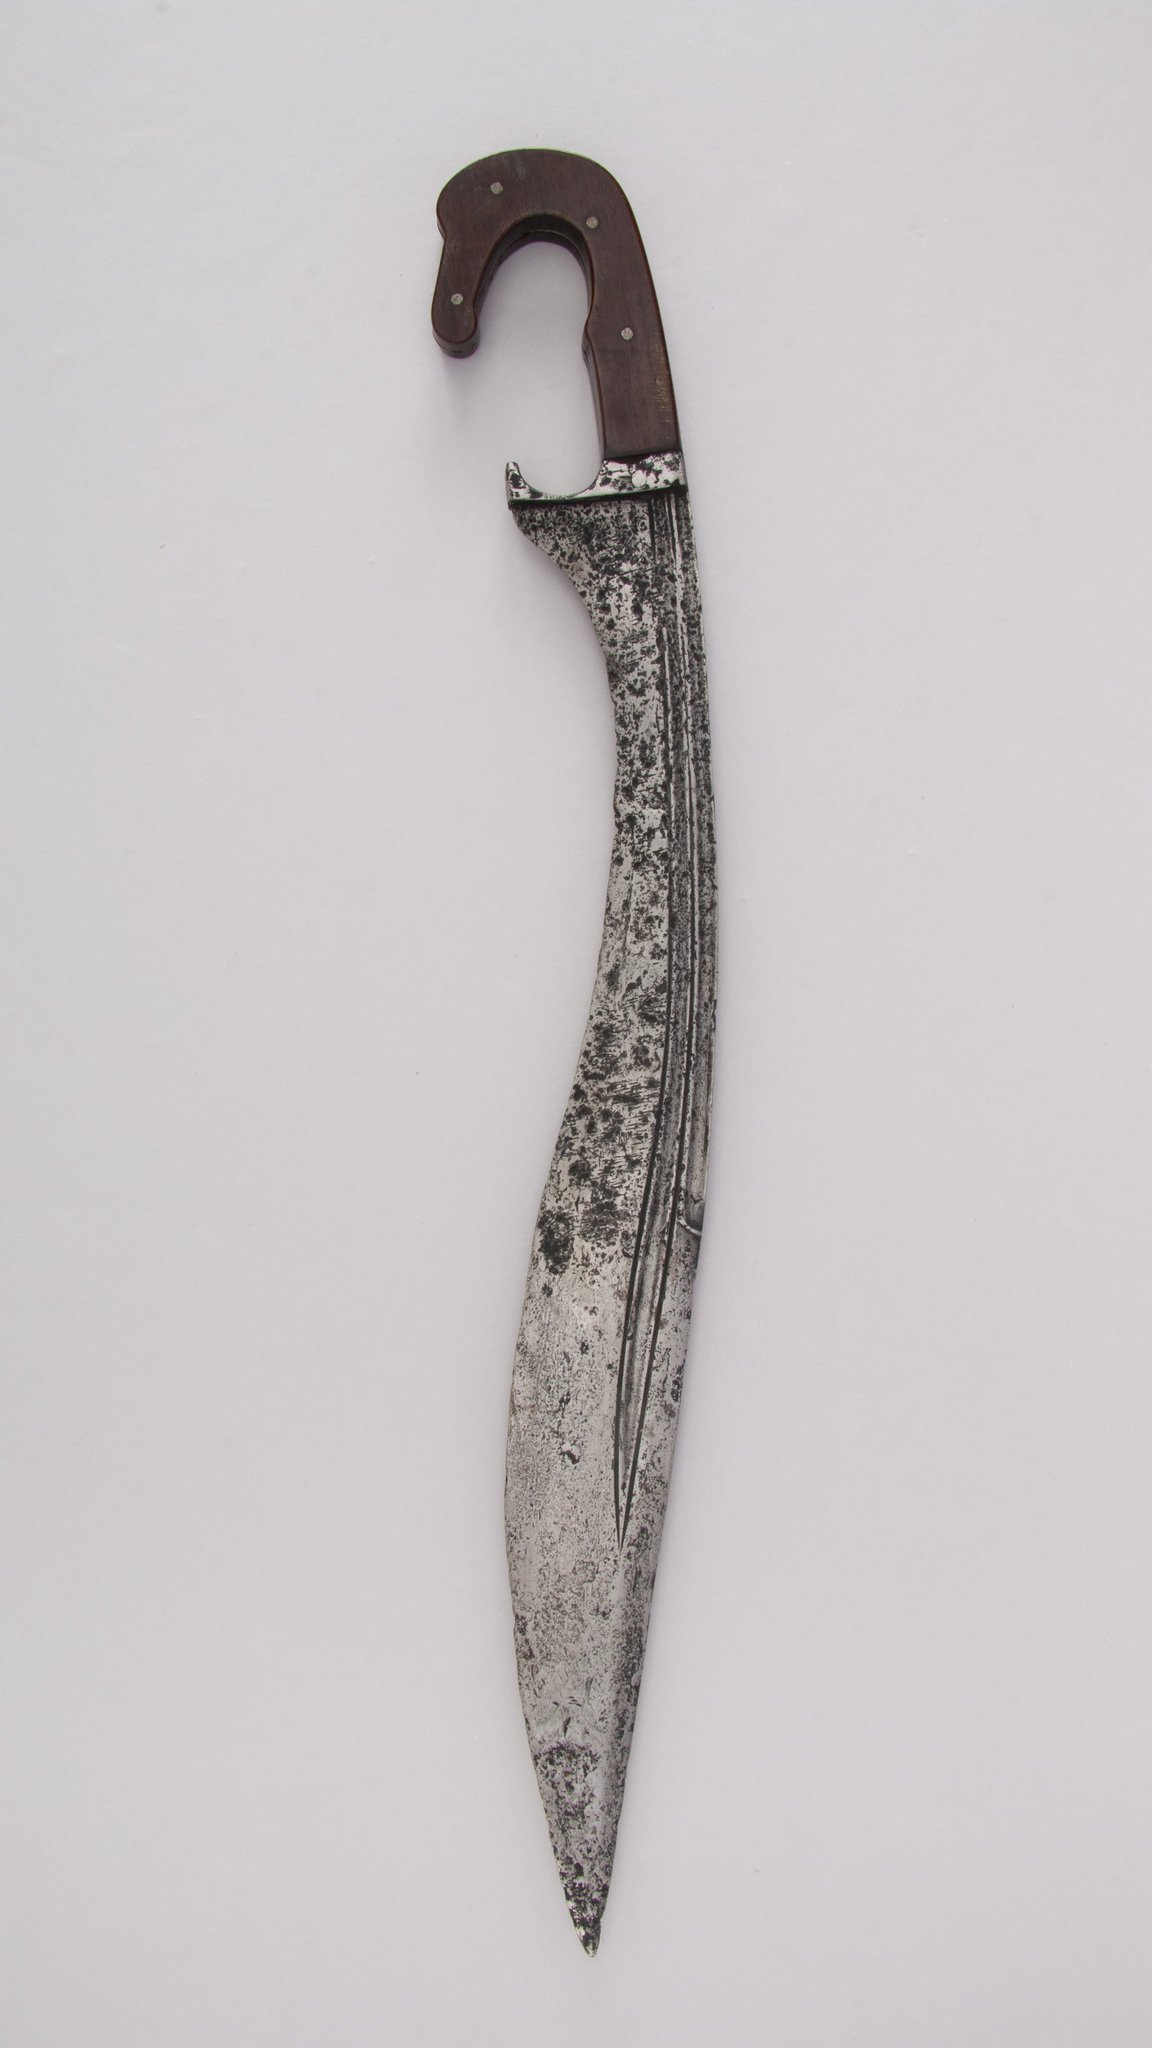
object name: sword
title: Sword (Falcata)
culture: iberian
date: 500-1 BCE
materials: metal alloy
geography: iberian peninsula